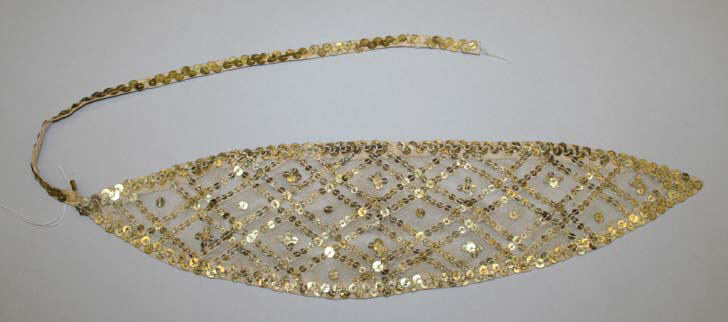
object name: headdress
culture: french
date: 1790-1820